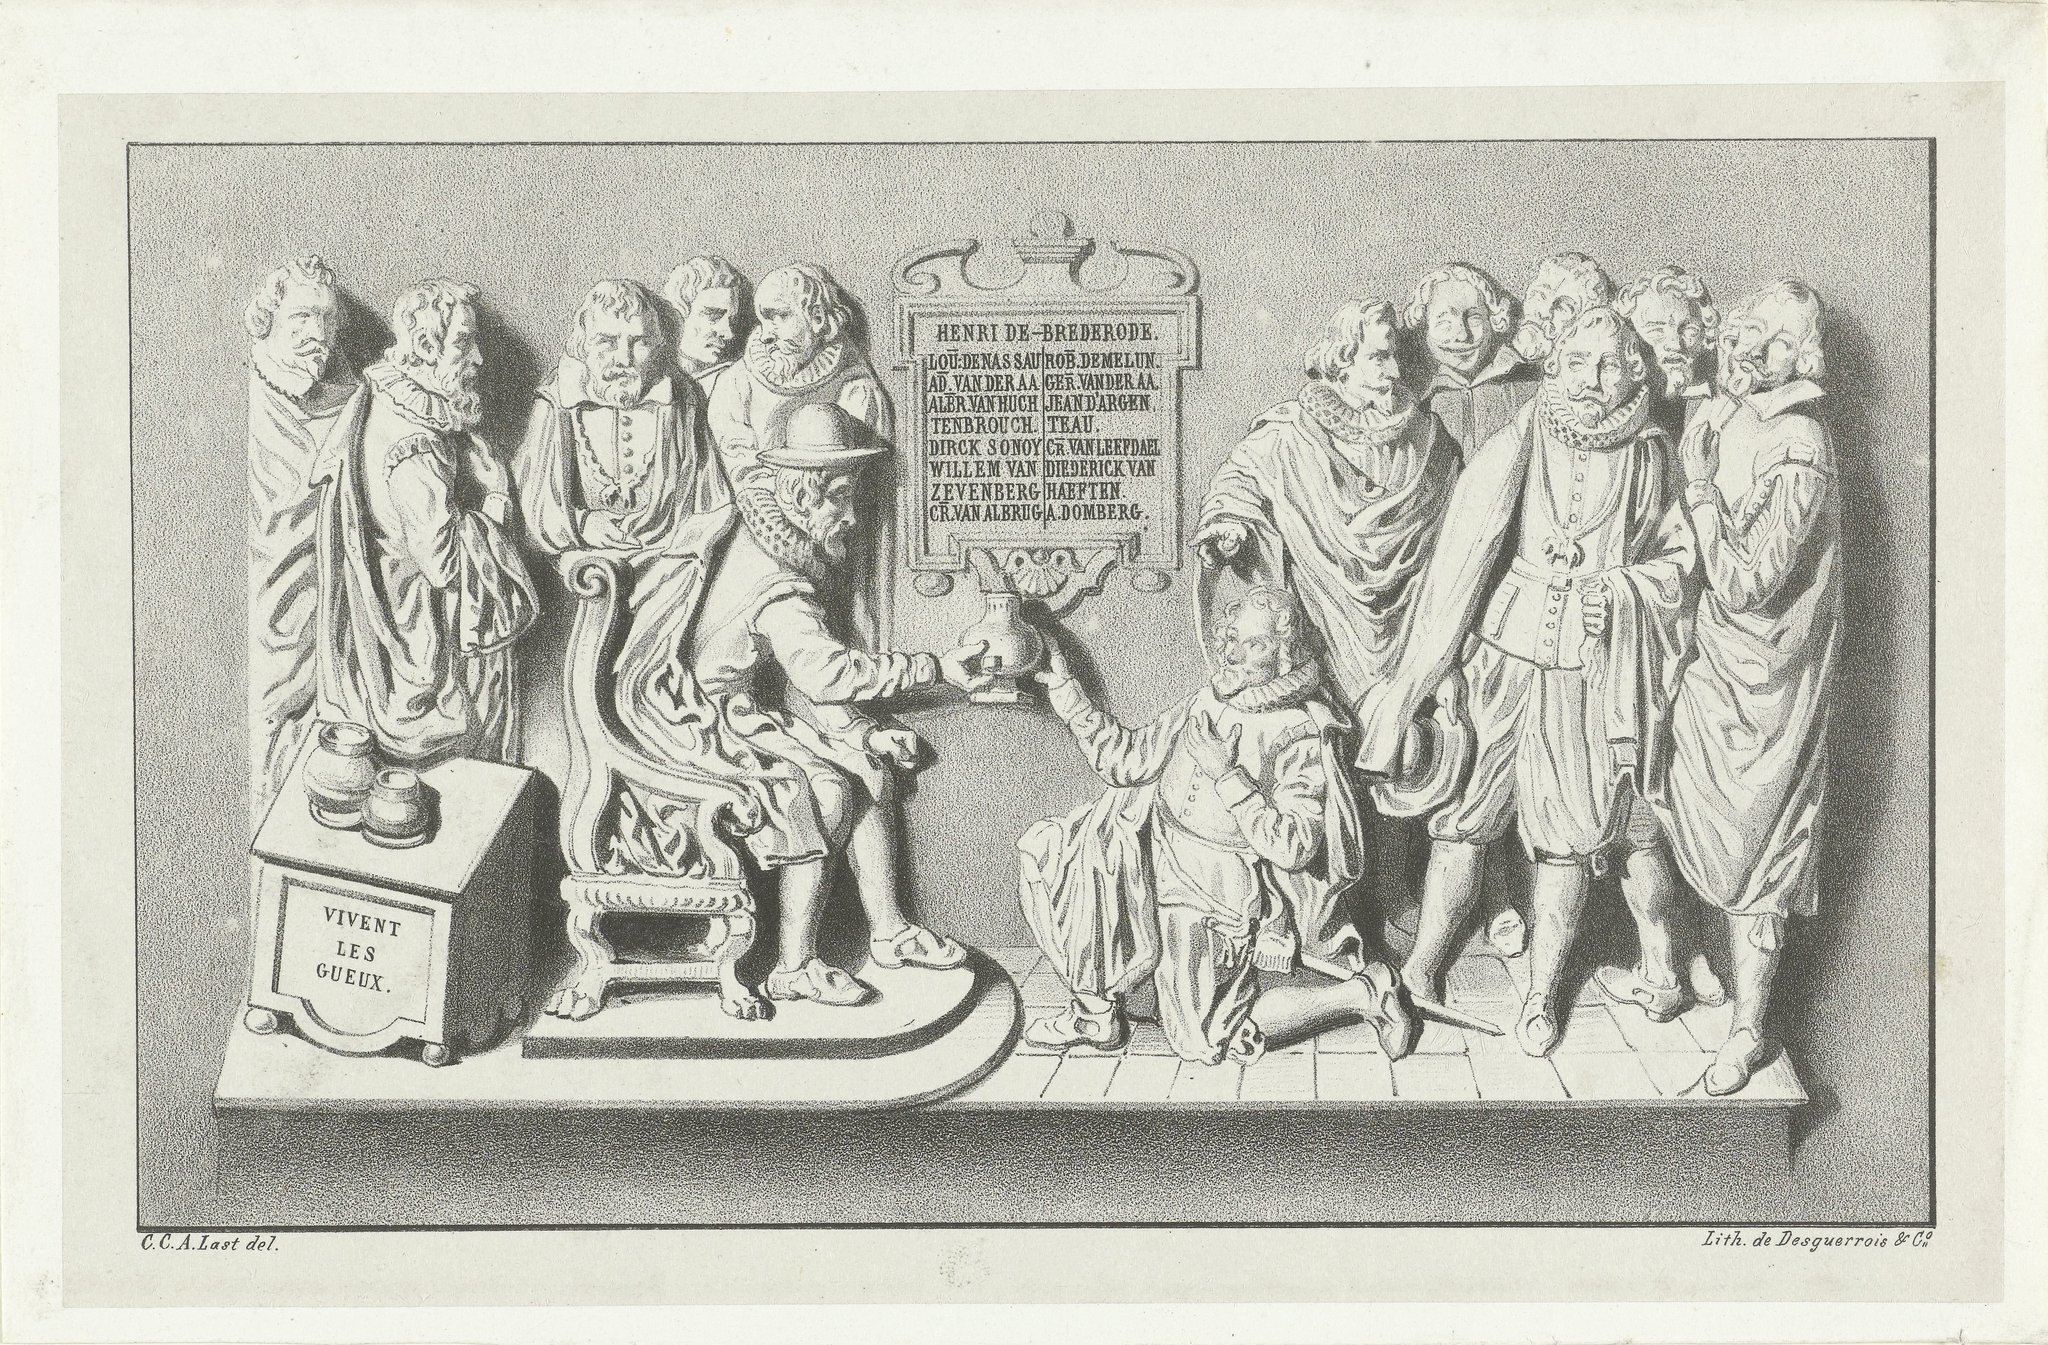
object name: historical object representation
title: Reliëf met Hendrik van Brederode en andere edelen uit het Verbond, 1566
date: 1842-1844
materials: paper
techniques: lithograph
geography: netherlands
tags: hendrik van brederode (heer van vianen), verbond der edelen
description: Reliëf met Hendrik van Brederode en andere edelen uit het Verbond, 1566. Brederode biedt geknield een zittende man een geuzennap aan. Hierachter elf andere staande edelen wier namen op een plaquette staan vermeld. Illustratie uit een werk over Hendrik van Brederode, initiatiefnemer van het Verbond der Edelen en het Smeekschrift.